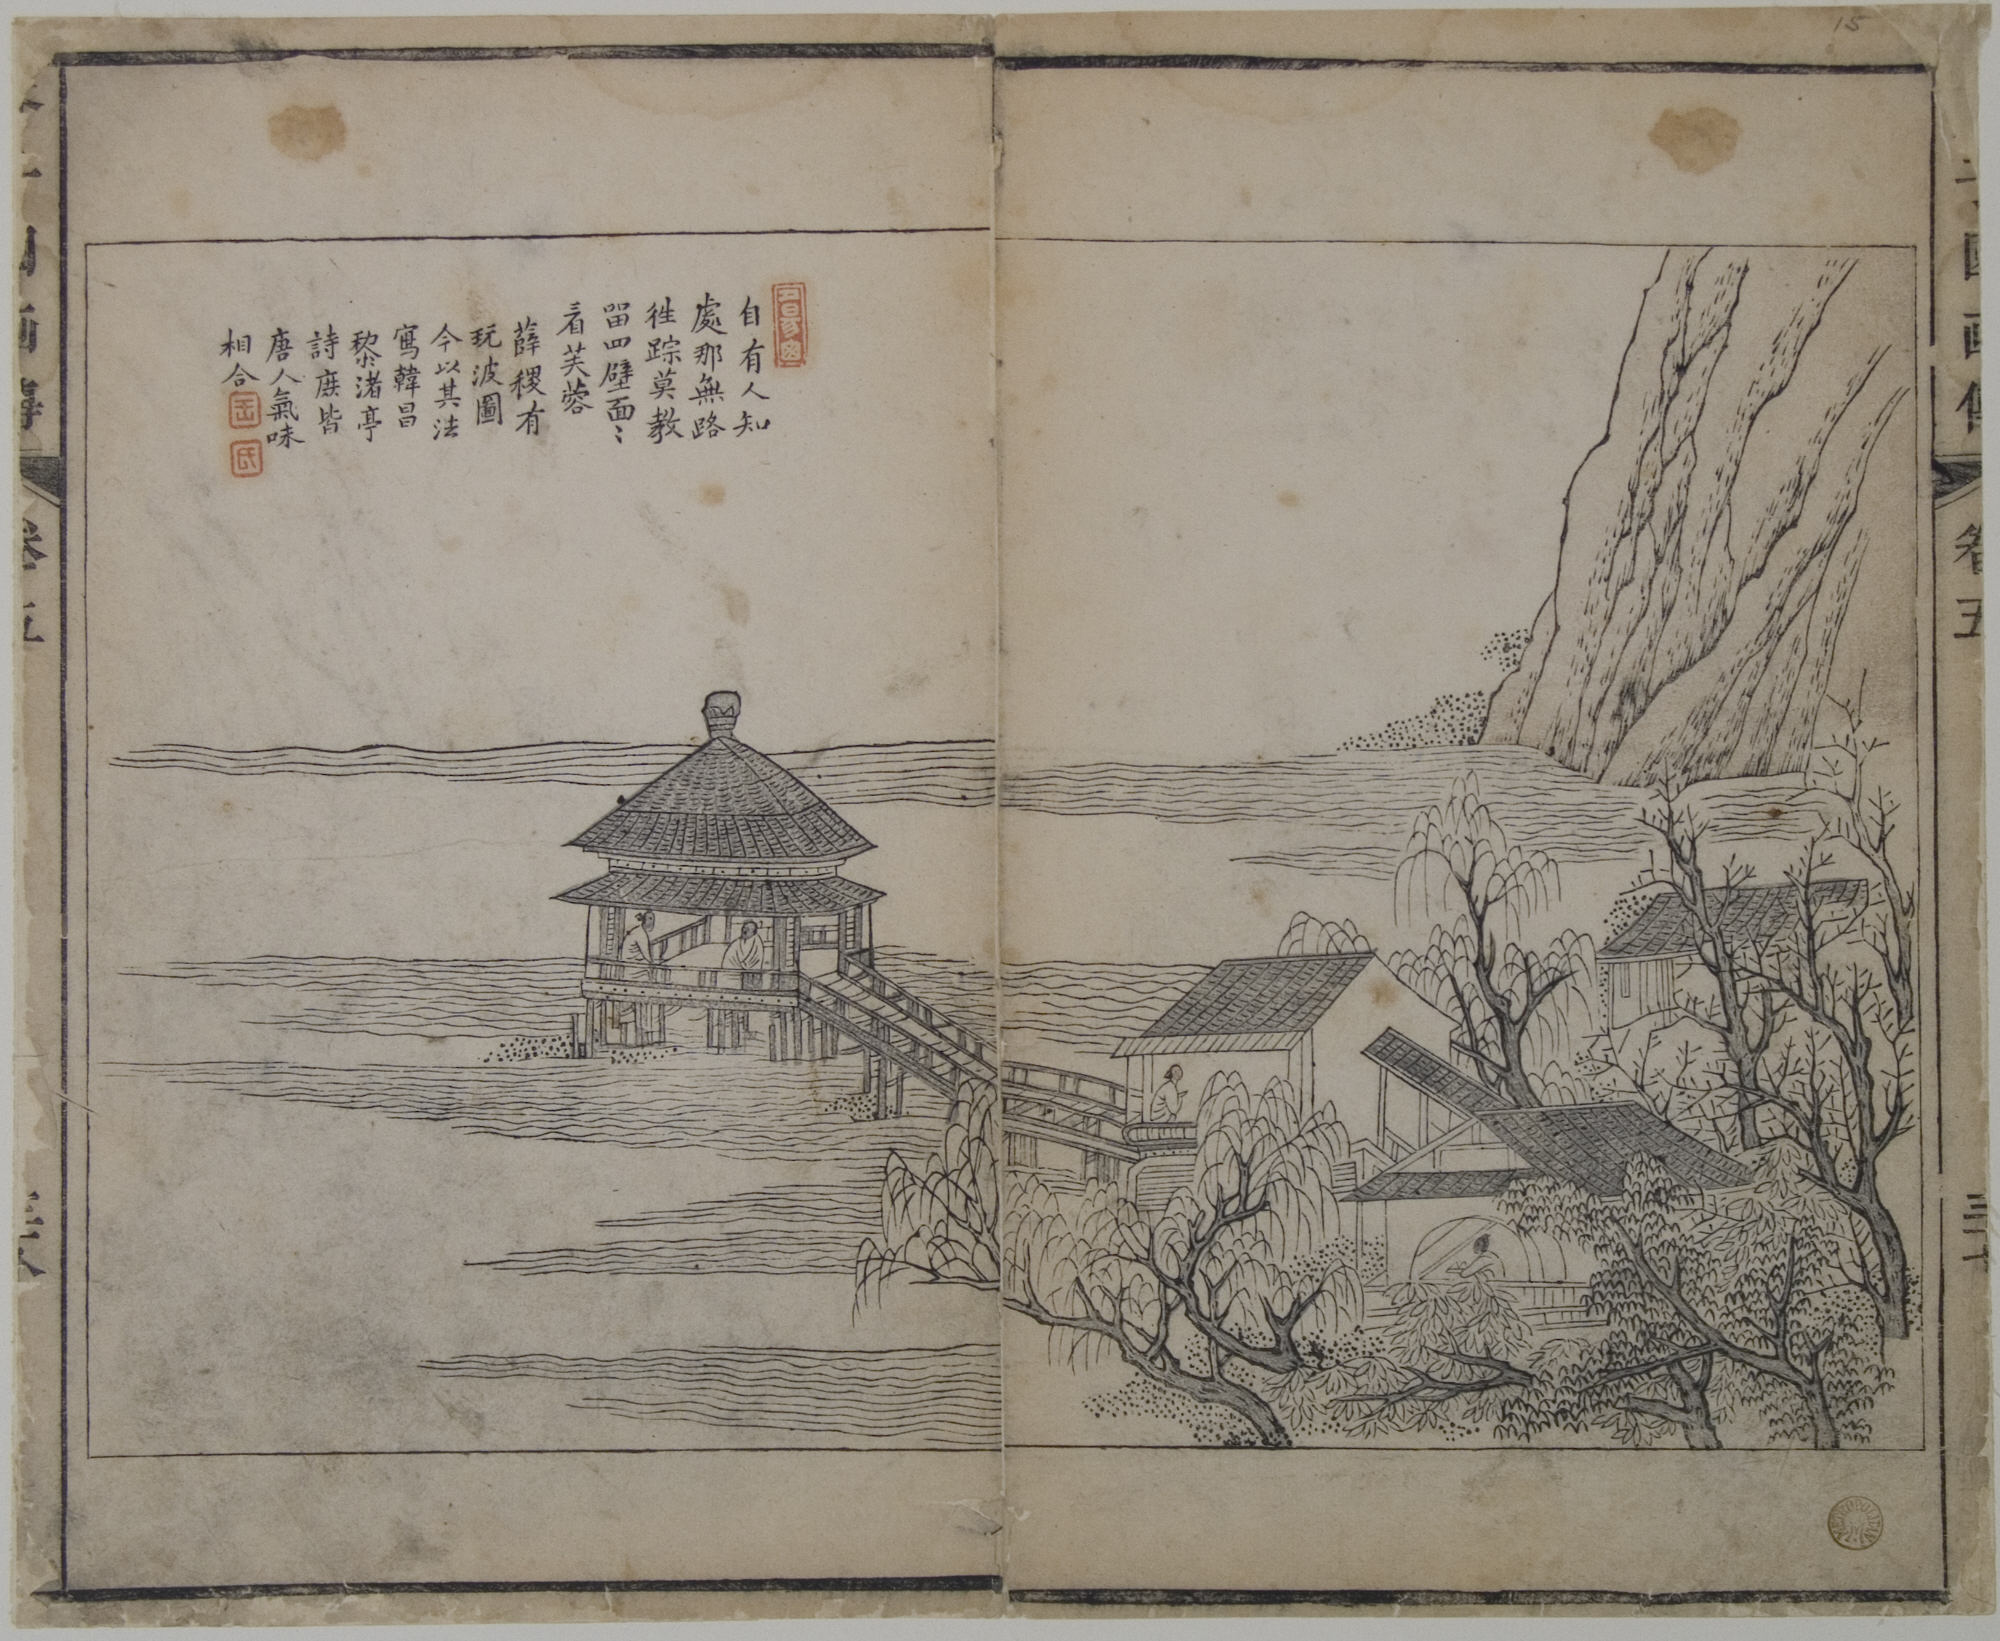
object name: print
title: Page from the Mustard Seed Garden Manual of Painting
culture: chinese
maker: wang gai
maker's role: artist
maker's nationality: chinese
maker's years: 1645-1710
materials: ink, paper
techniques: woodblock print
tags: landscapes,trees